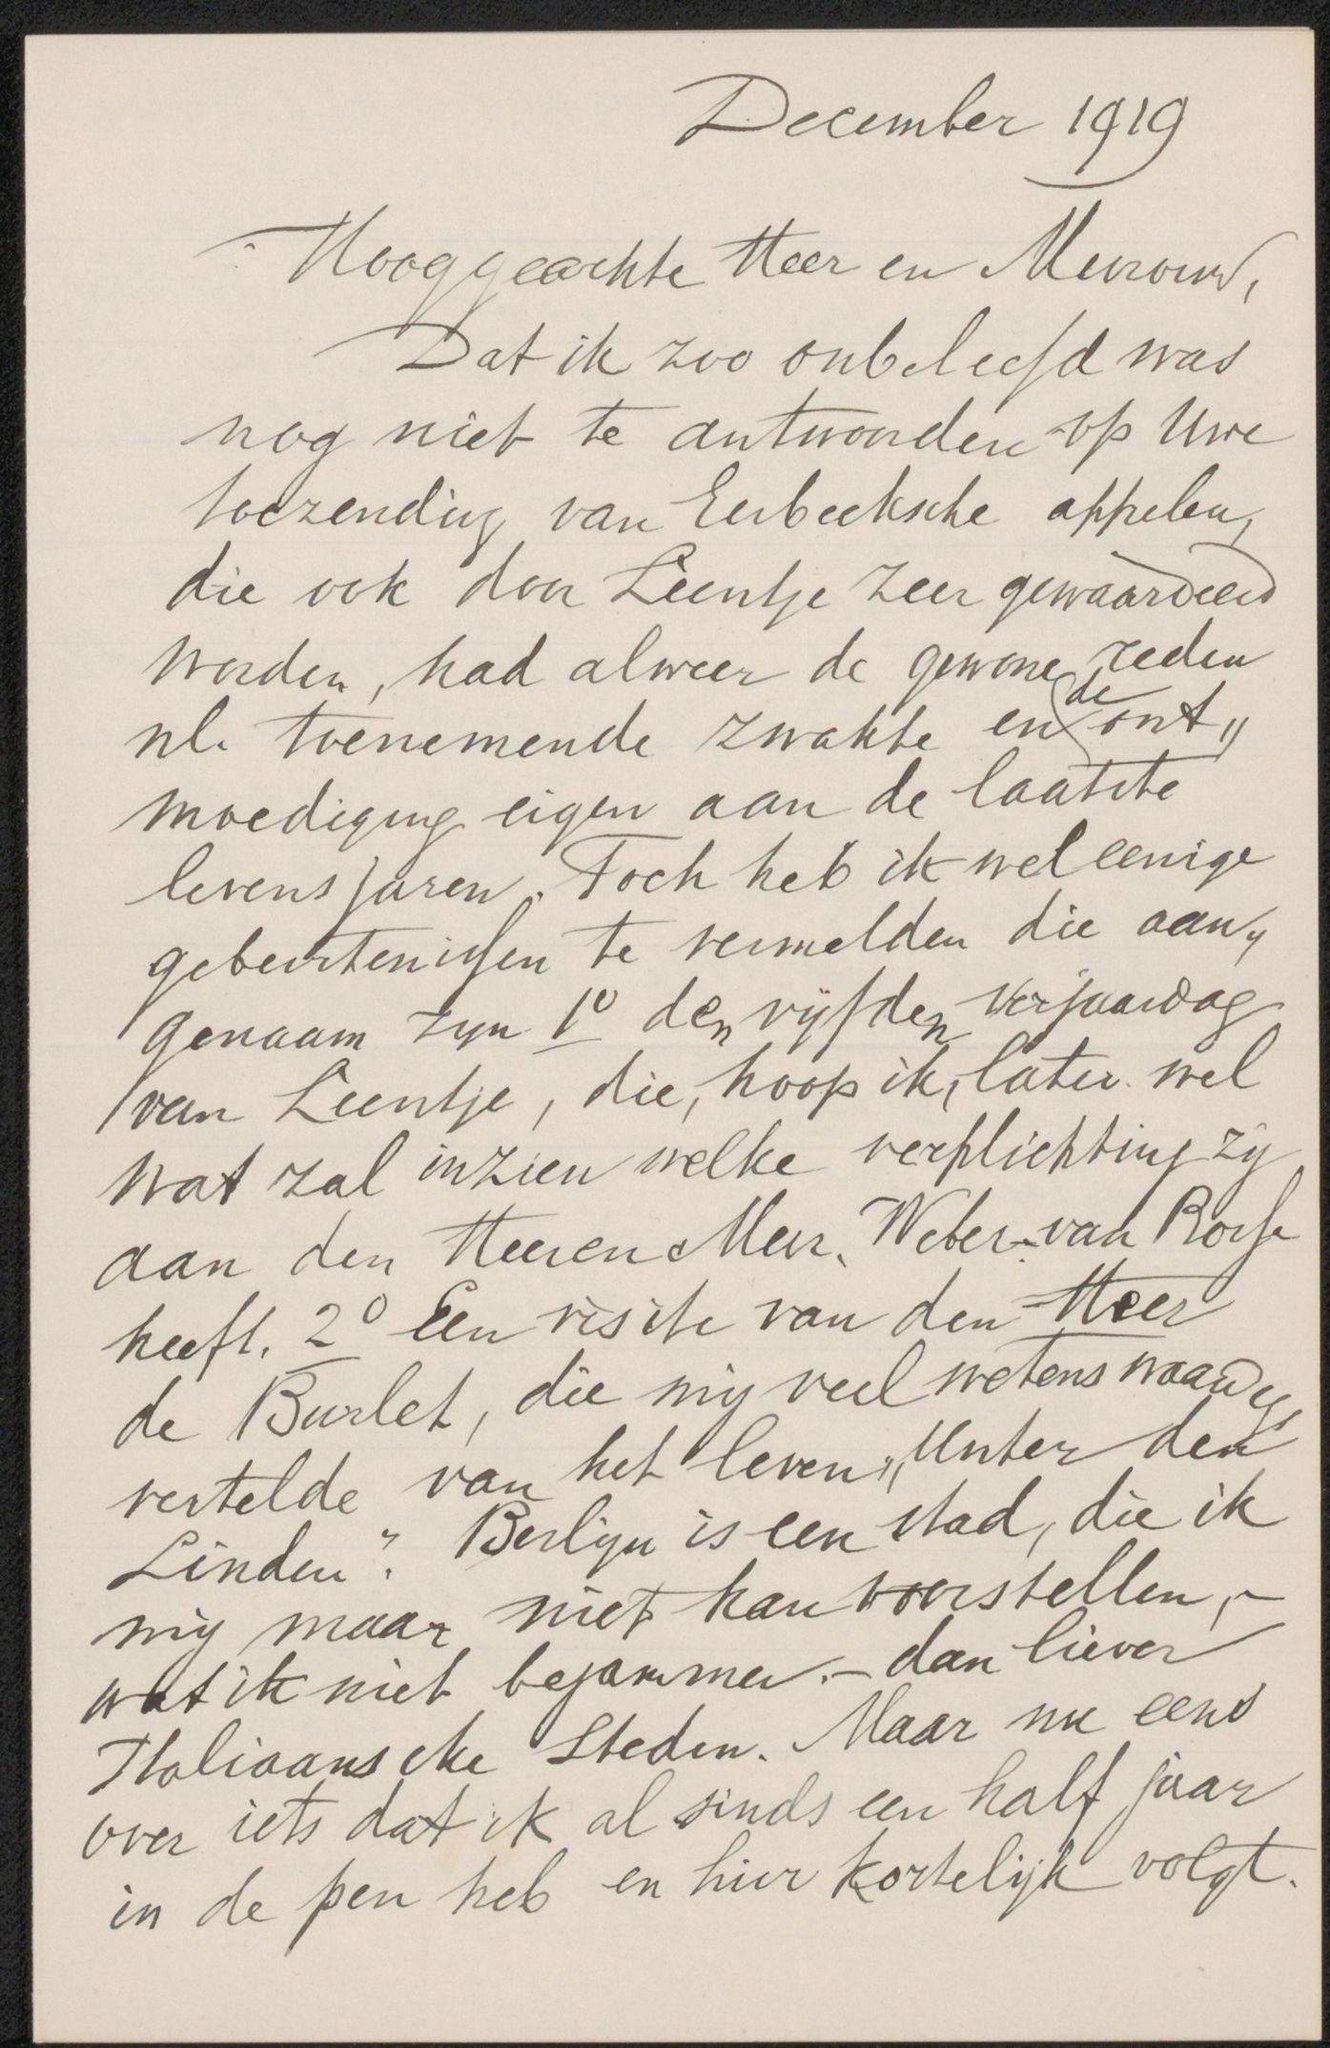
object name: letter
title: Brief aan Max Wilhelm Carl Weber en Anne Antoinette Weber-Van Bosse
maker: august allebé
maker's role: draughtsman, print maker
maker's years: 1838-1927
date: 1912-1919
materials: ink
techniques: pen, writing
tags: albert charles auguste plasschaert, rotterdam, charles albert de burlet, amsterdam, anne antoinette weber-van bosse, art trade, art shop, drawing, art collecting, berlin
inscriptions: watermark